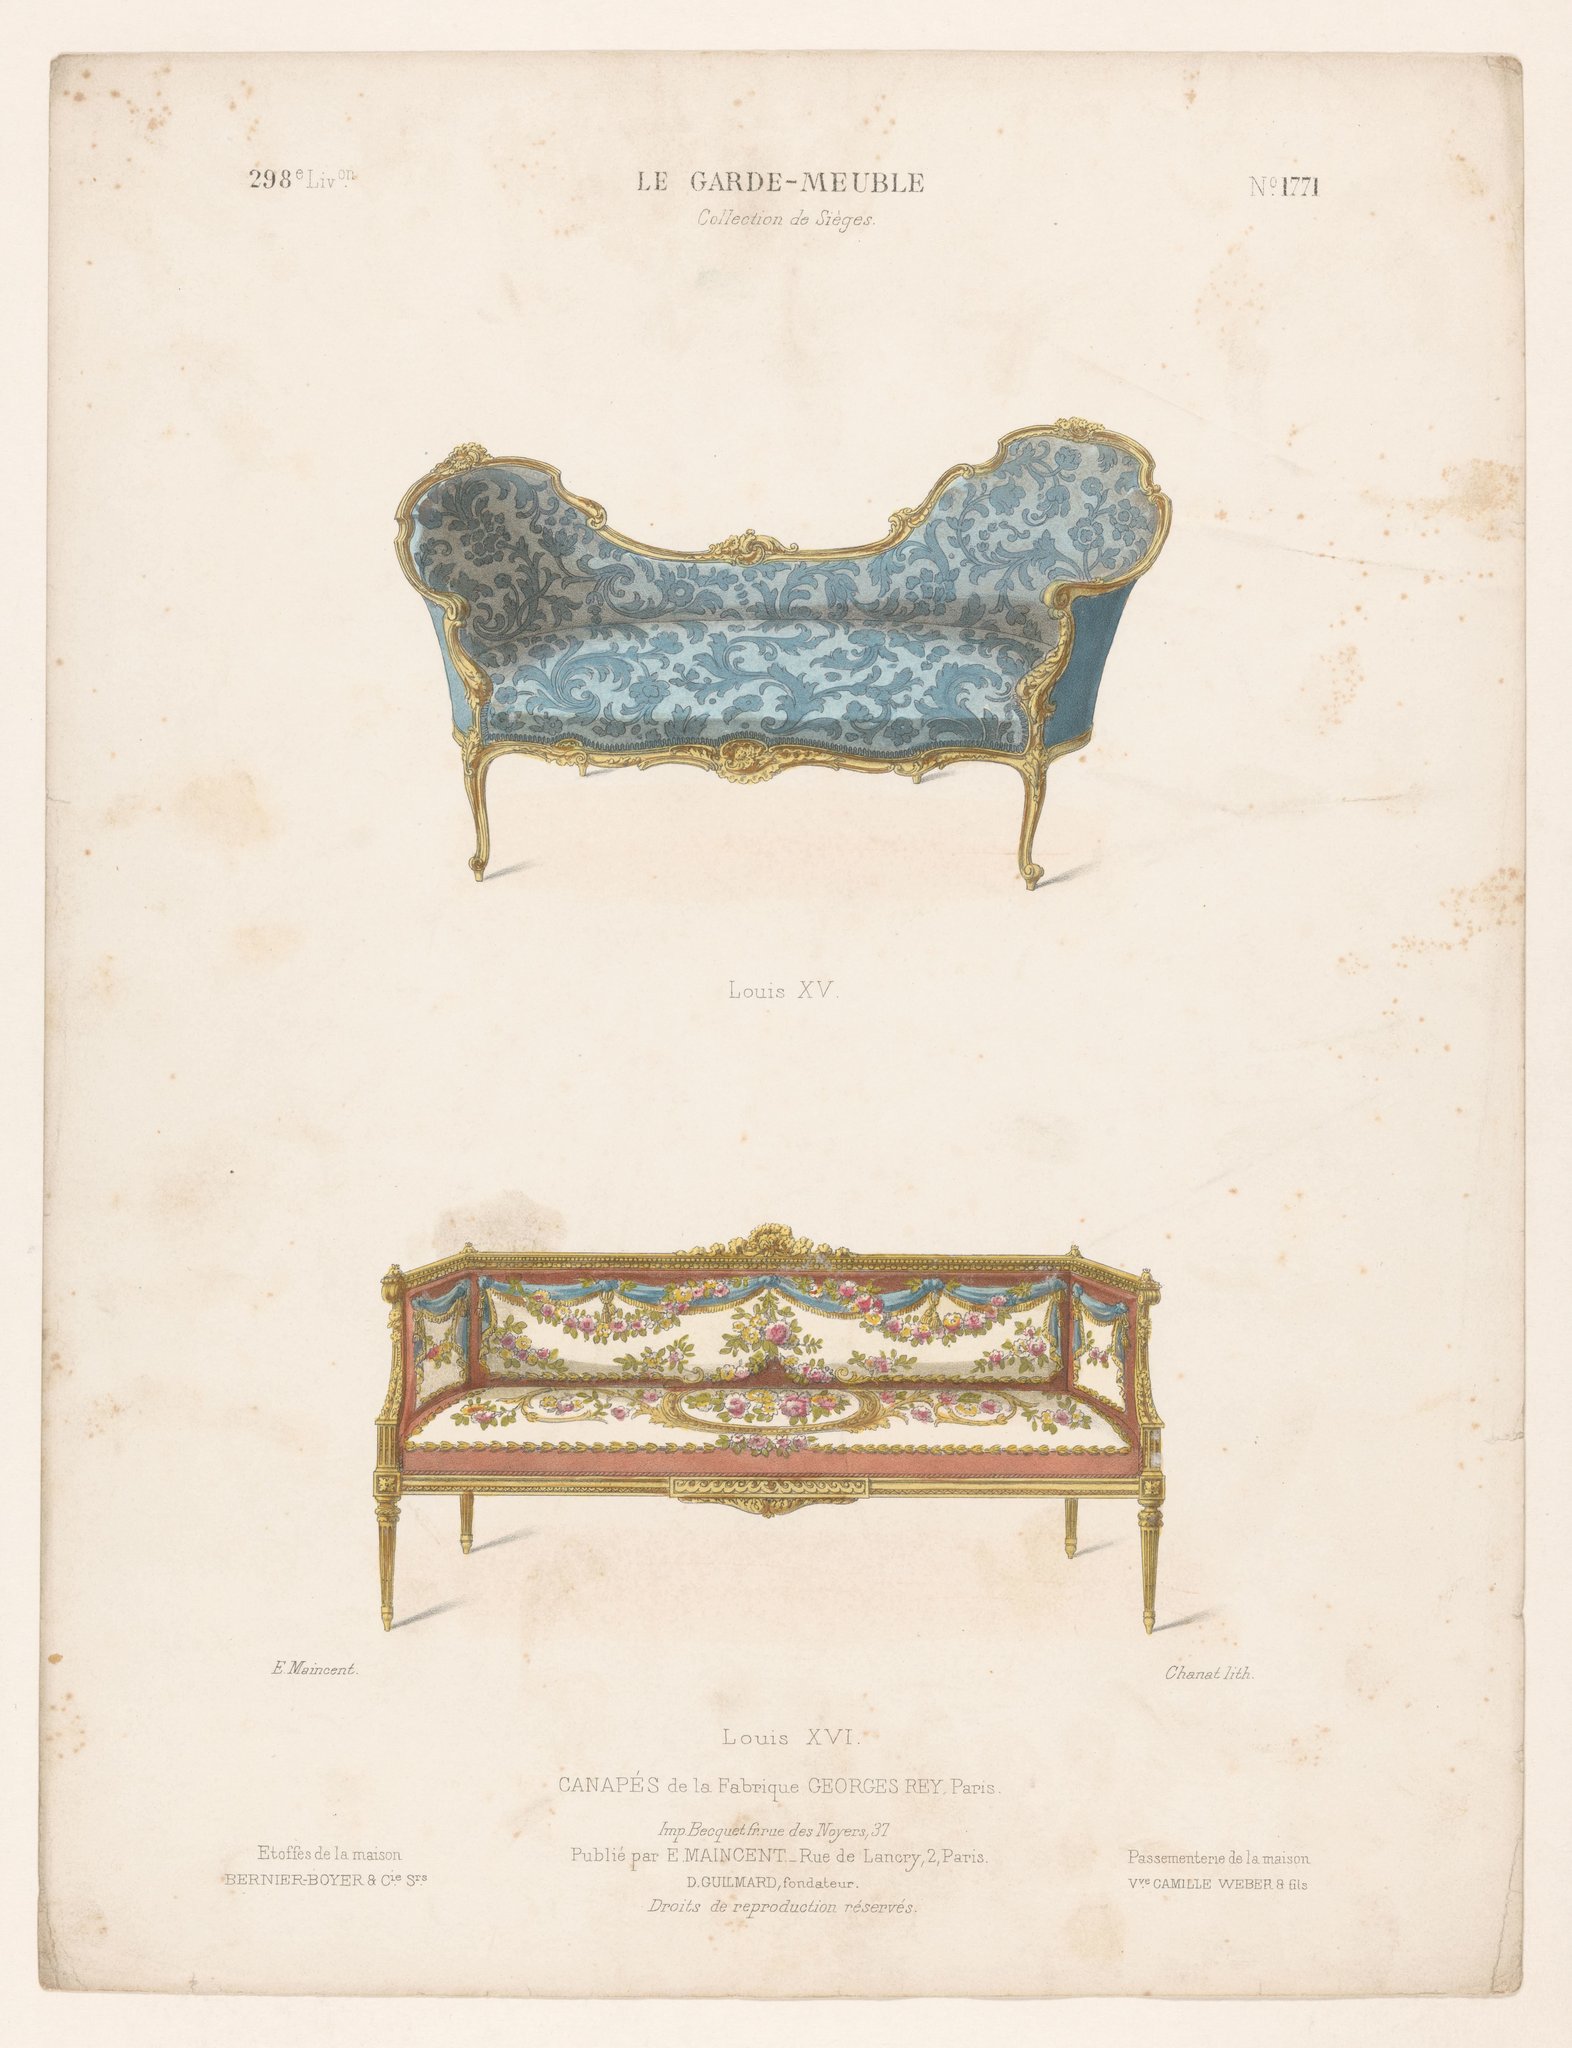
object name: print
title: Canapés / Louis XV / Louis XVI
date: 1885-1895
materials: paper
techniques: hand coloring, lithograph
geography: paris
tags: seating furniture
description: Ieder Livraison in de serie Le Garde-Meuble bevat negen platen: drie 'sièges' (zitmeubels), drie 'meubles' (diverse meubels zoals tafels en kasten) en drie 'tentures' (gordijnen en draperieën).